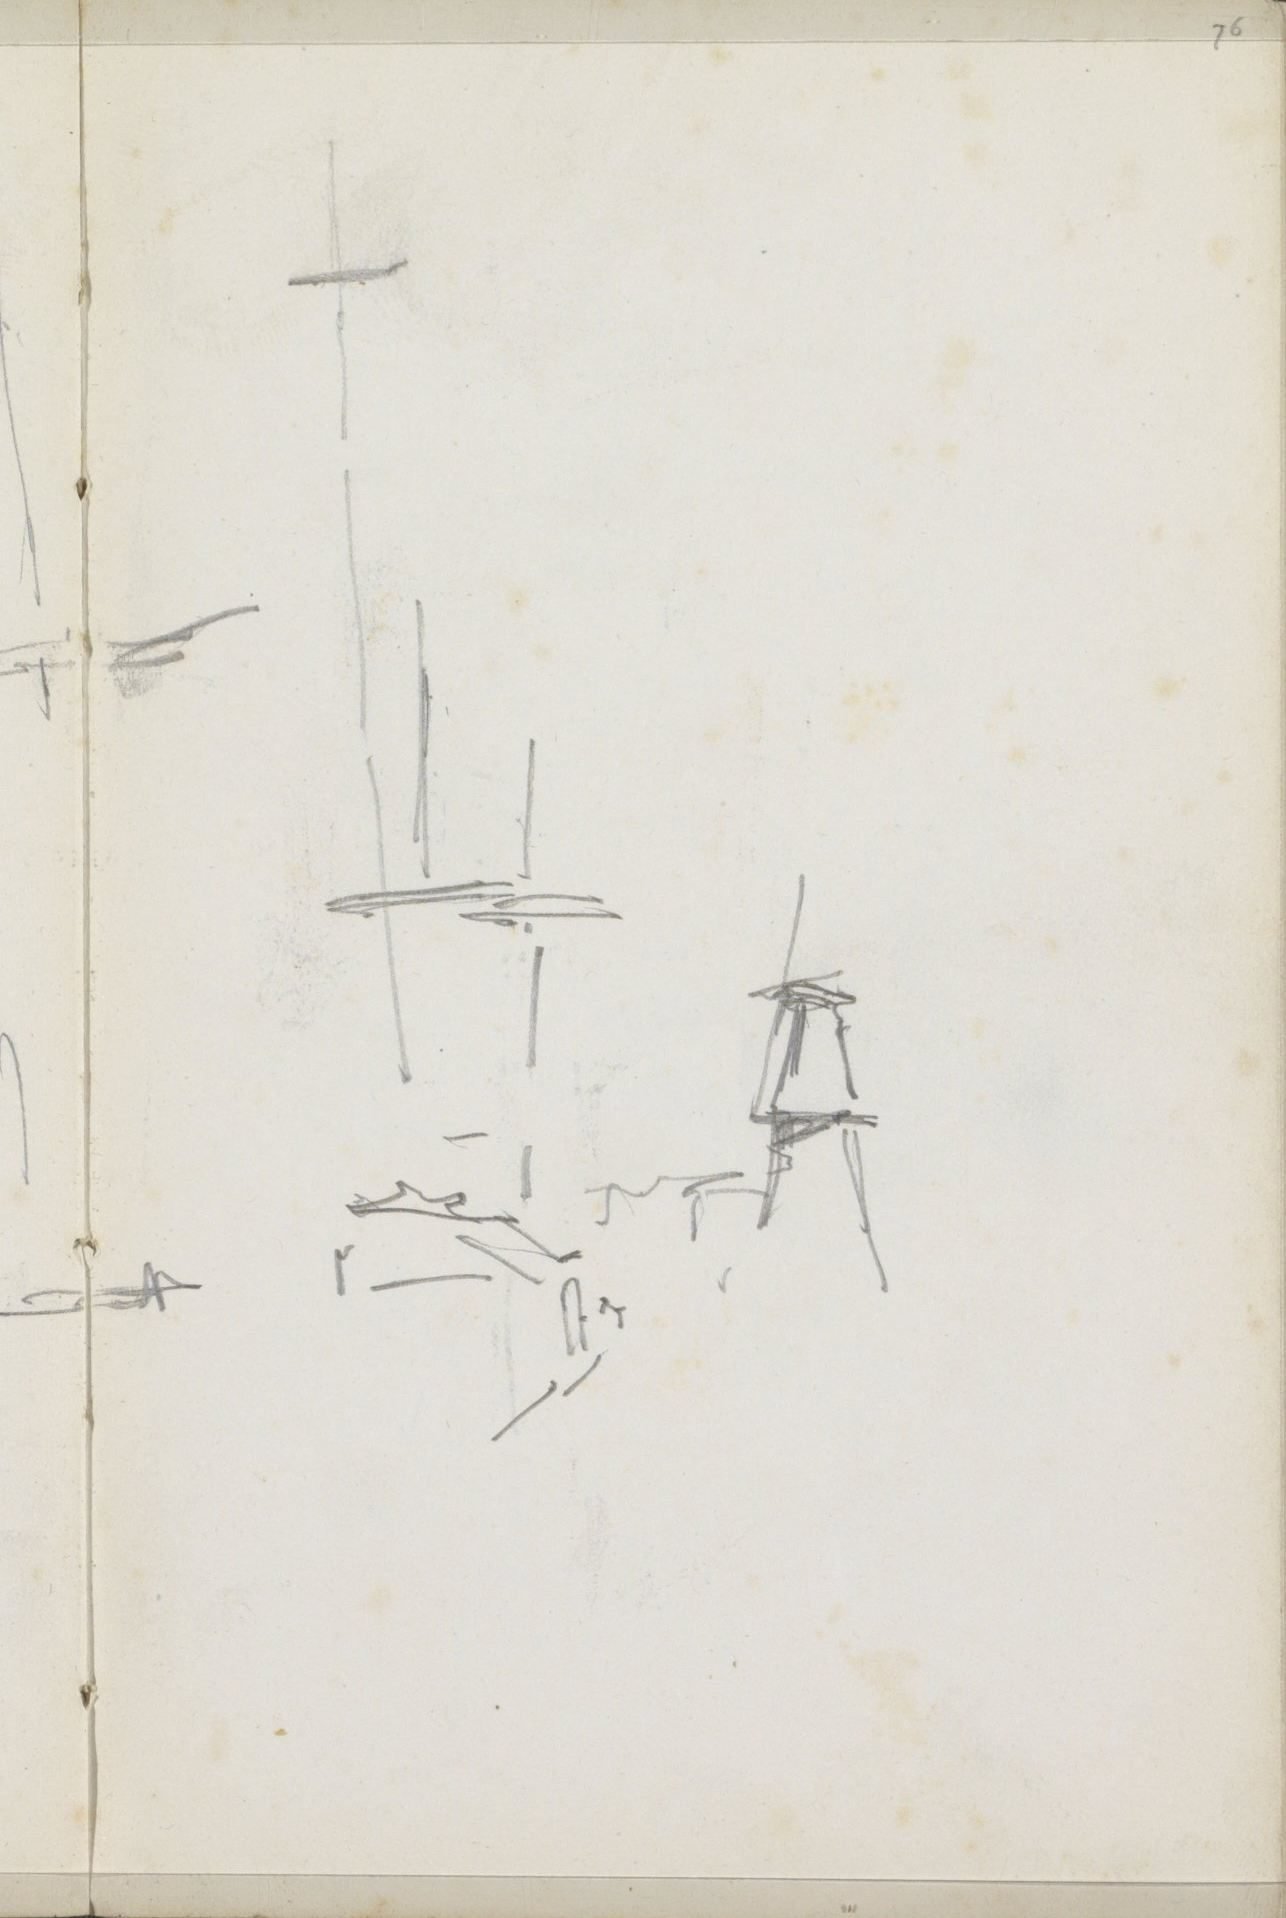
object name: sketchbook leaf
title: Stadsgezicht met een molen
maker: george hendrik breitner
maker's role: draughtsman, painter, print maker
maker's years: 1857-1923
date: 1880-1882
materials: paper, pencil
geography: gorinchem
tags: city-view, and landscape with man-made constructions, windmill, civic architecture; edifices; dwellings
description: Mogelijk Gorinchem. Pagina 76 uit een schetsboek met 72 bladen.